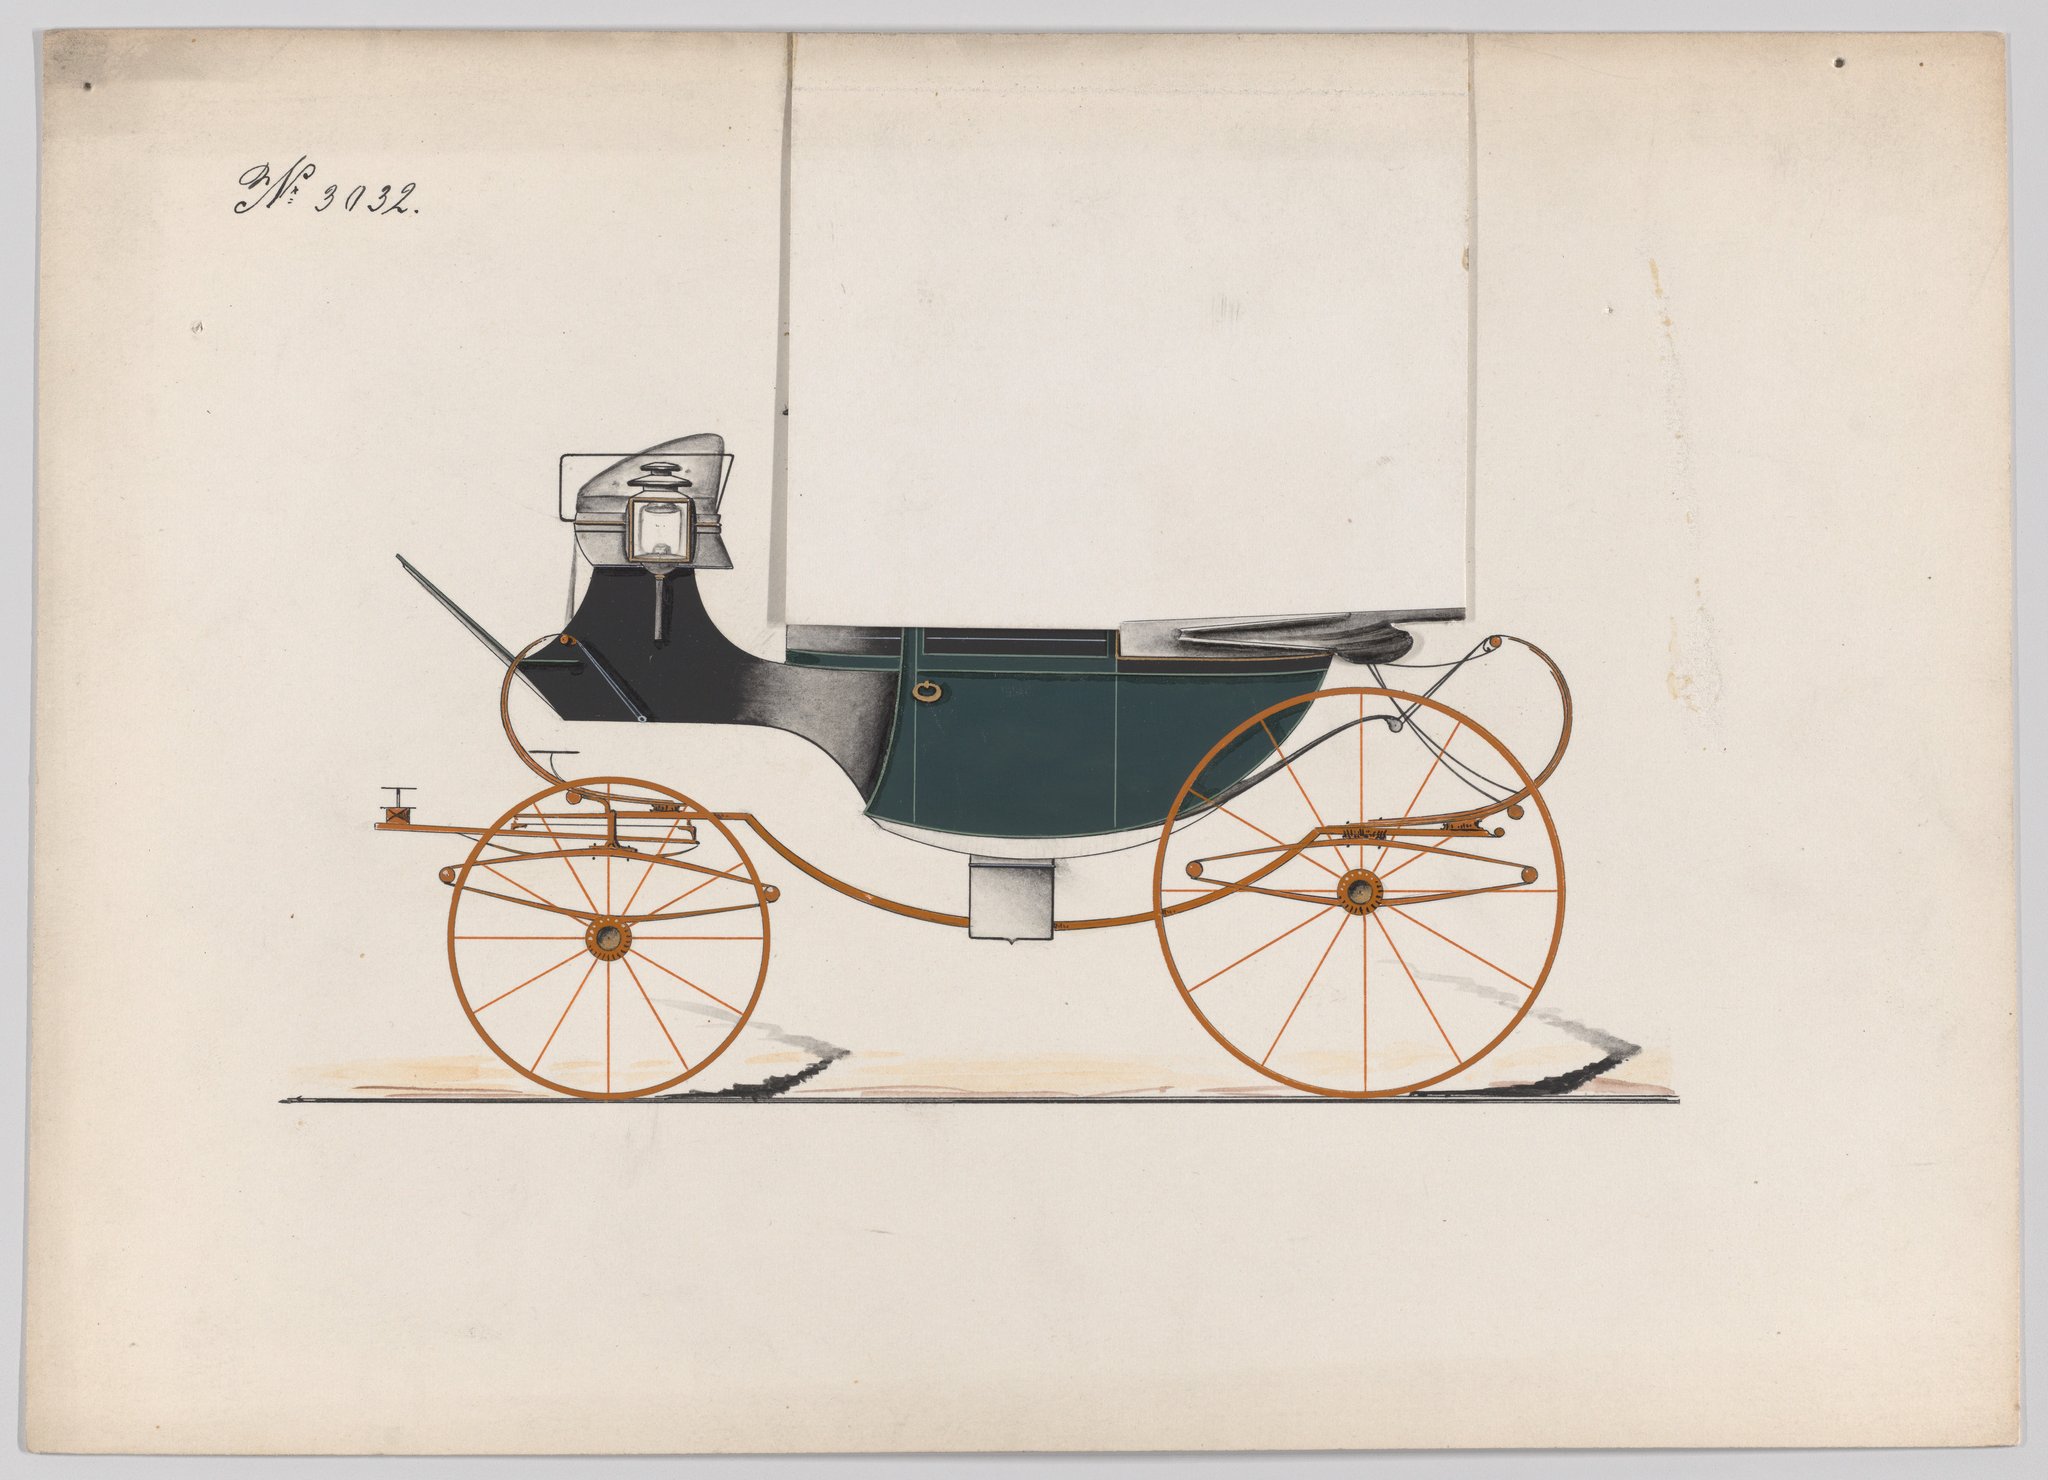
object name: drawing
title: Design for Landaulet, no. 3032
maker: brewster & co.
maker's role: manufacturer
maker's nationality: american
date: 1874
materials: gouache, gum arabic, ink, watercolor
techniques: pen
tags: carriages